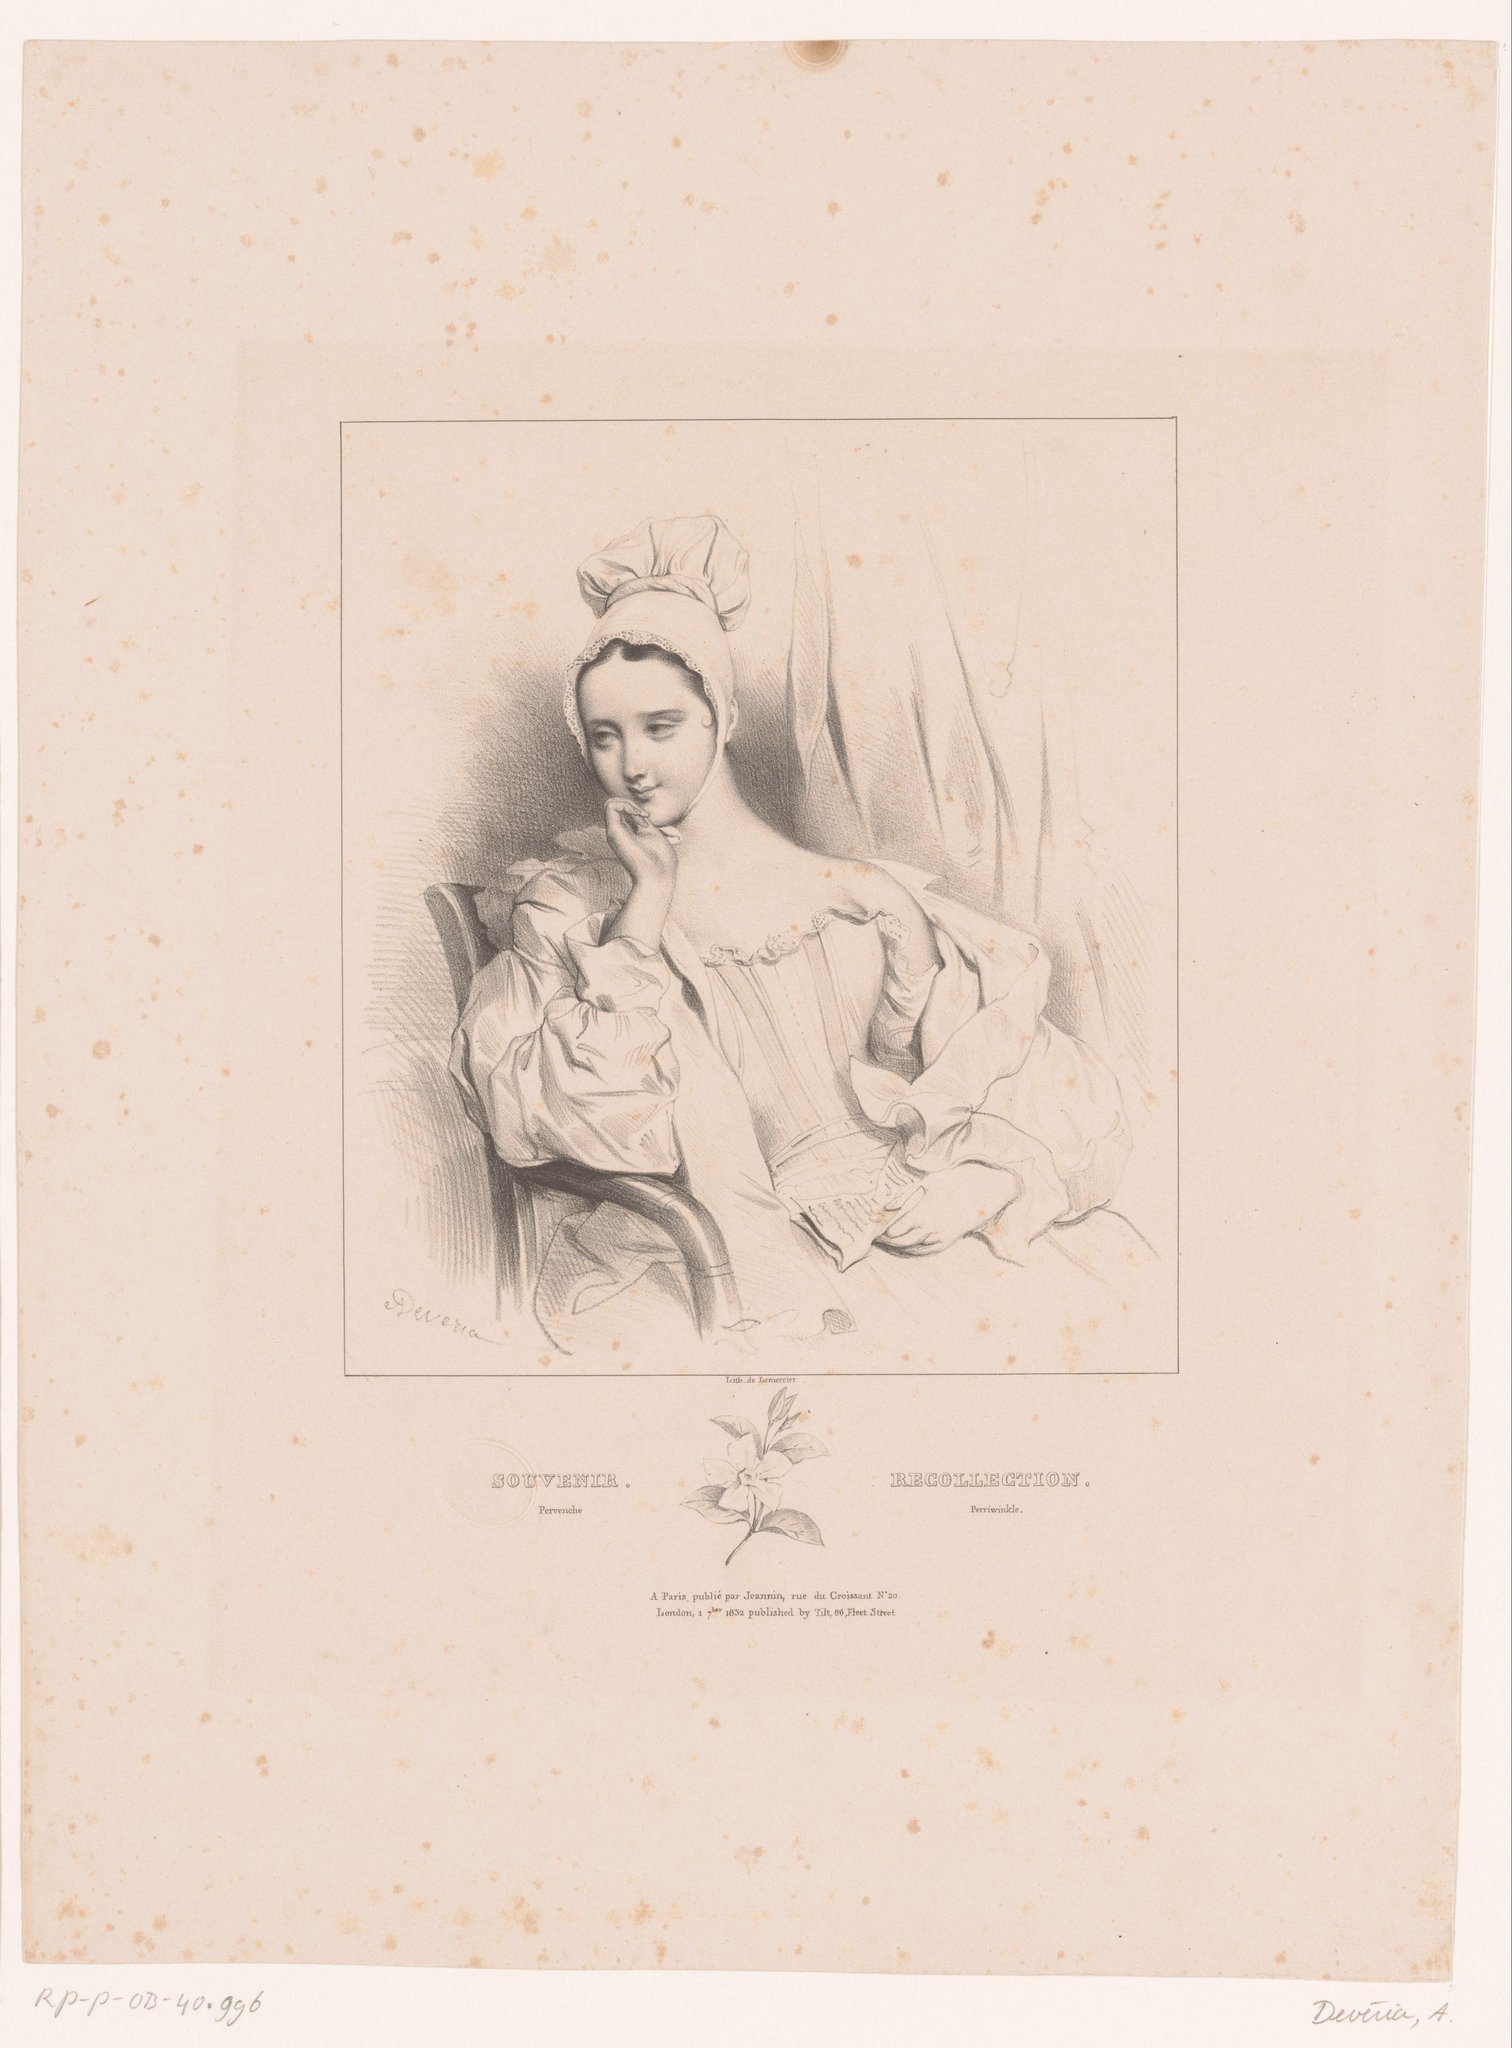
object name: print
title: Maagdenpalm en herinnering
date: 1831-1832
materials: paper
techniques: lithograph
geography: paris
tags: flowers, adolescent, young woman, maiden, thinking, thought, reflection; 'pensiero' (ripa)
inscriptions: check stamp: Lugt 3987